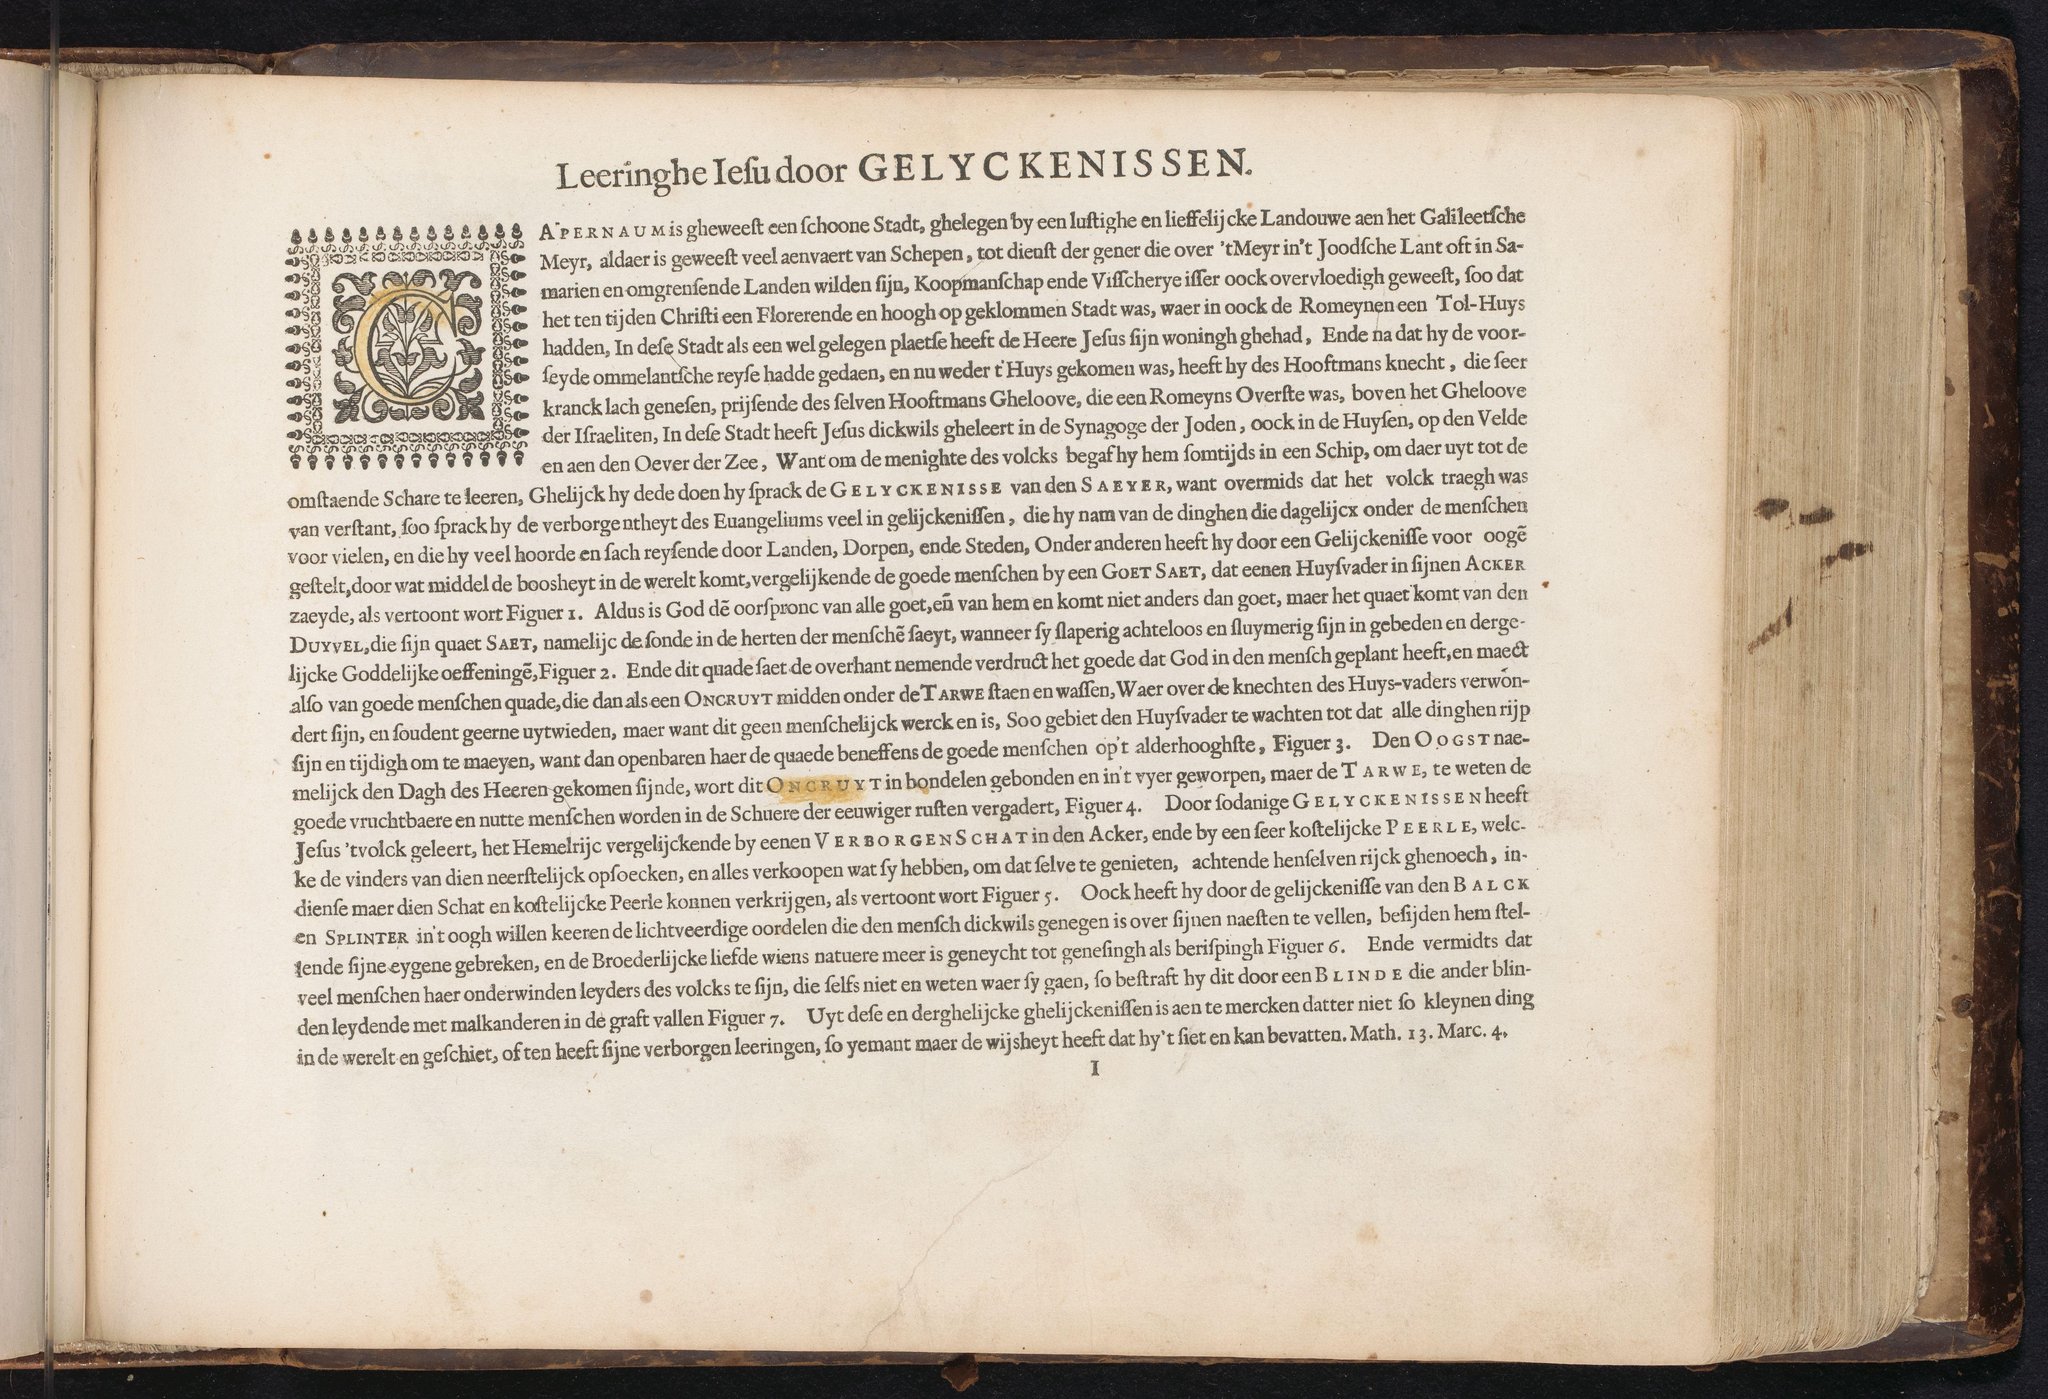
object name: album leaf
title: Den Grooten Figuer-Bibel (...)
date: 1646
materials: paper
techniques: hand coloring, letterpress printing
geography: alkmaar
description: Tekstblad bij een serie prenten over de gelijkenissen van Christus. Linksboven initiaal C. Dit blad maakt deel uit van een album.